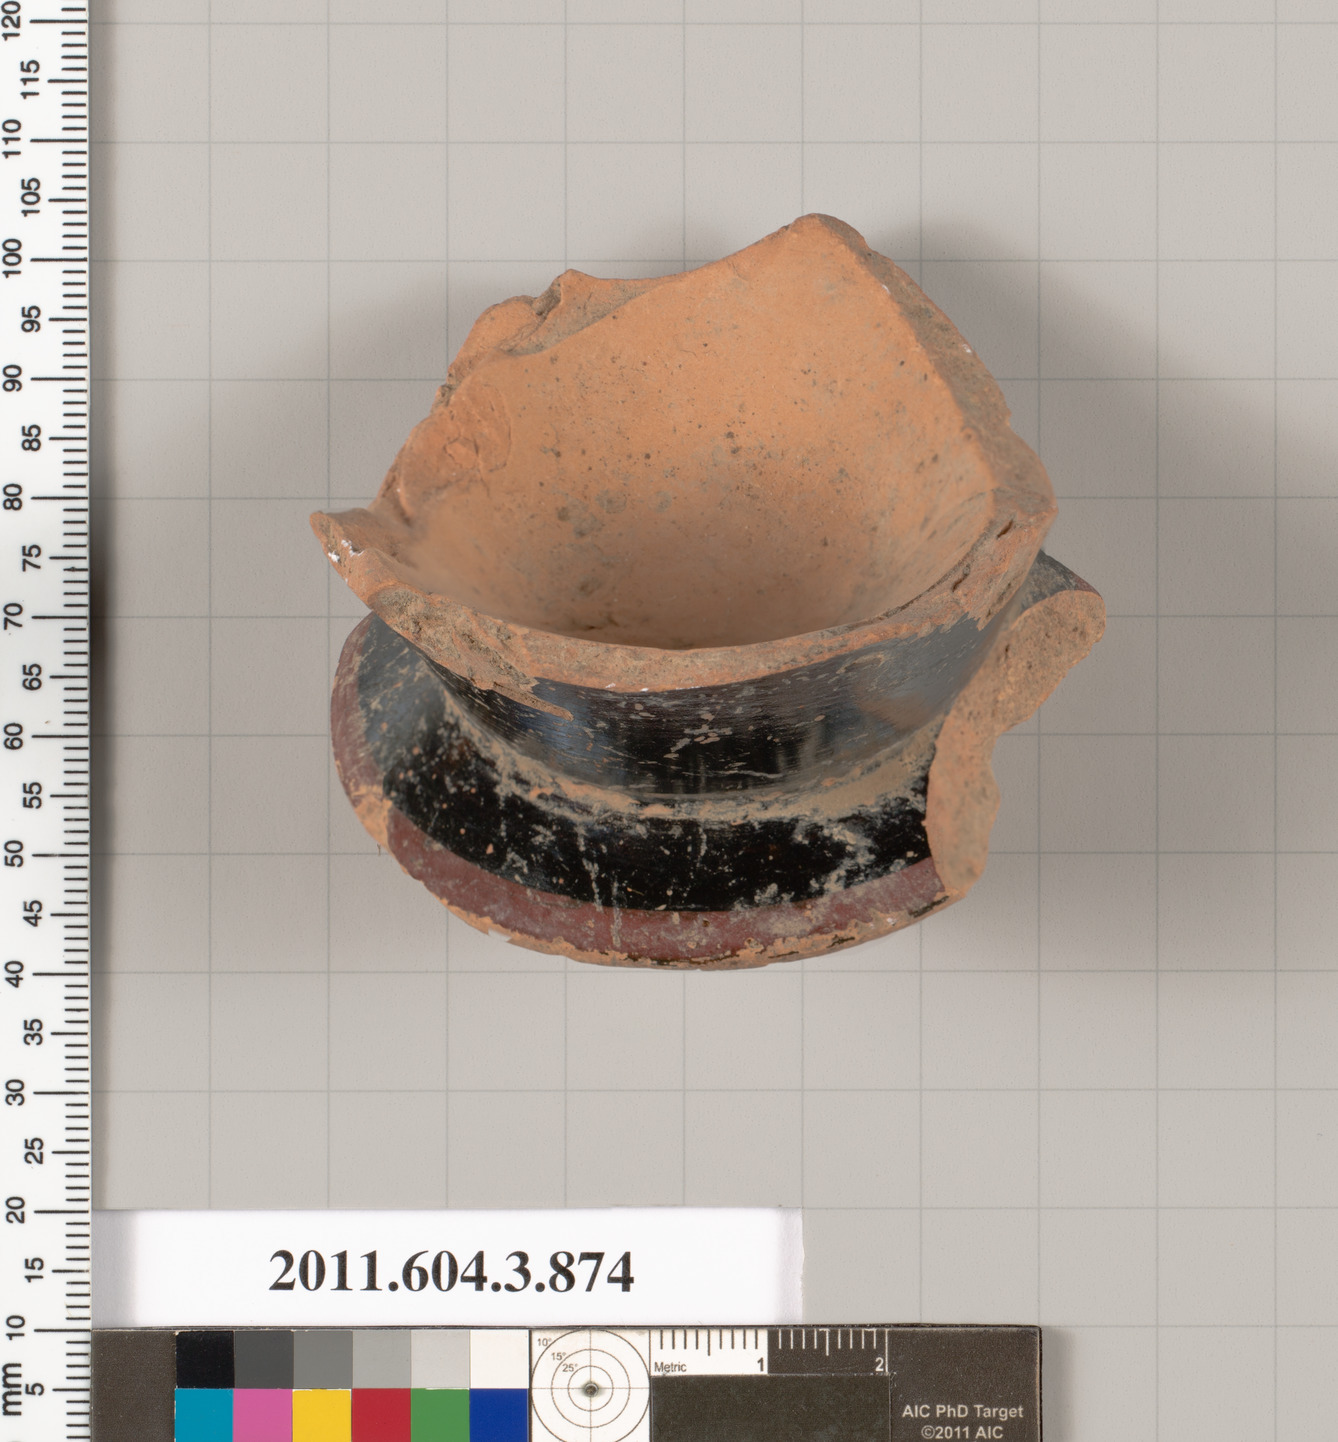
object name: lekythos fragment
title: Terracotta fragment of a lekythos (oil flask)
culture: greek, attic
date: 600-401 BCE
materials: terracotta